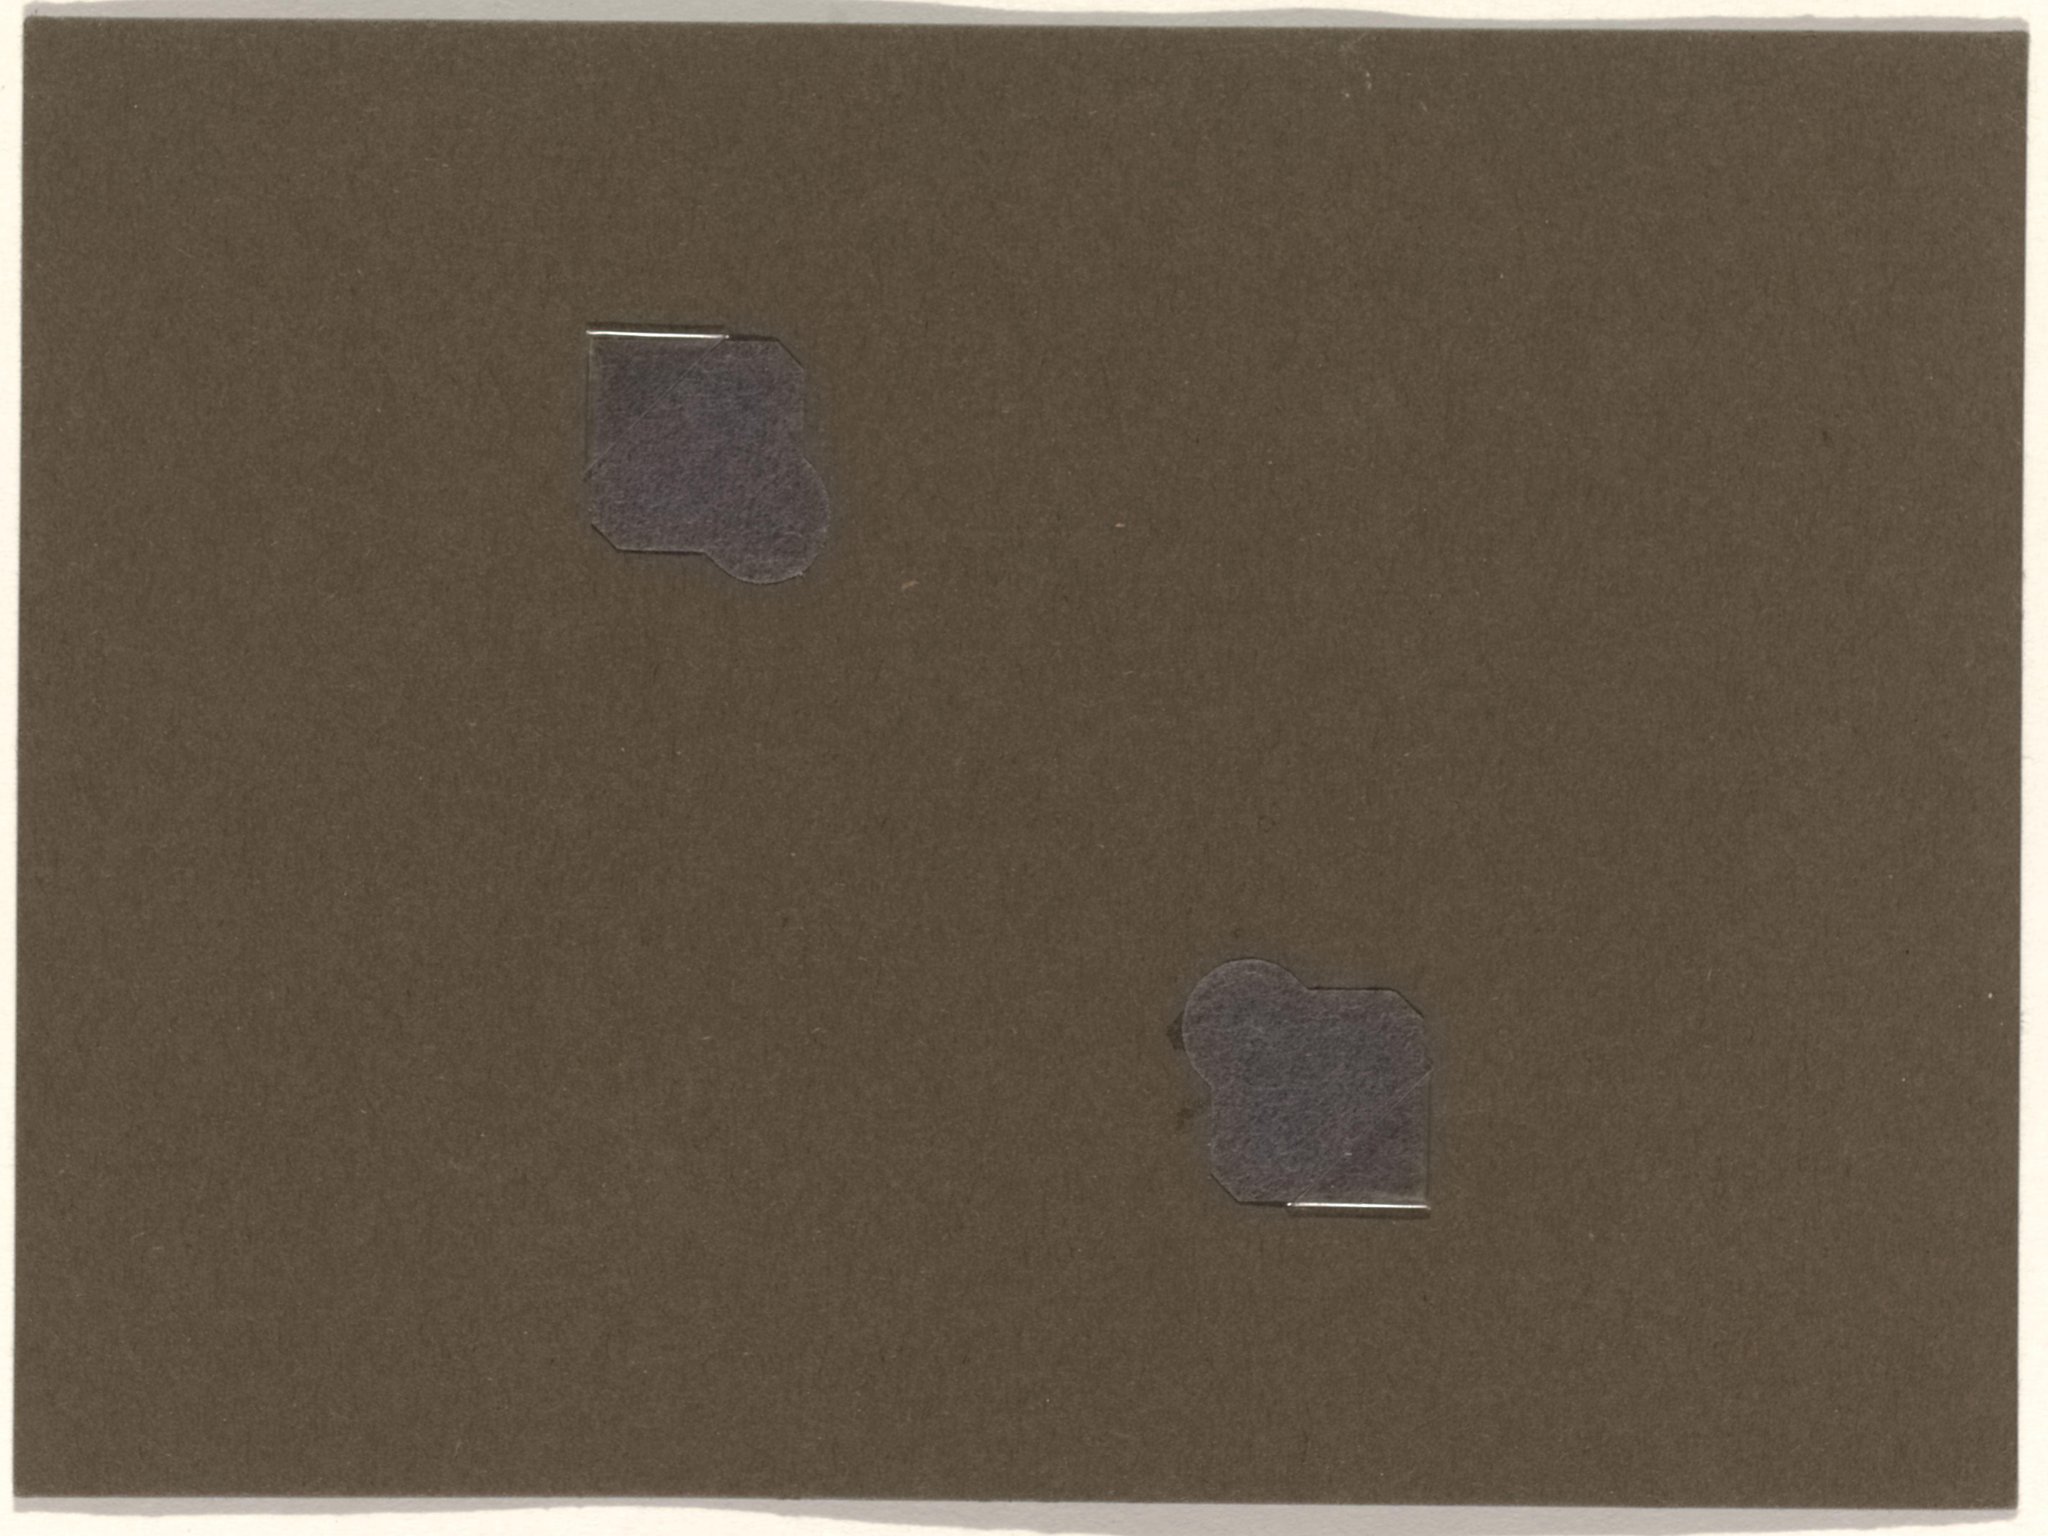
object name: photograph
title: Foto ontbreekt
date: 1928-1943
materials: photographic support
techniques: gelatin silver print